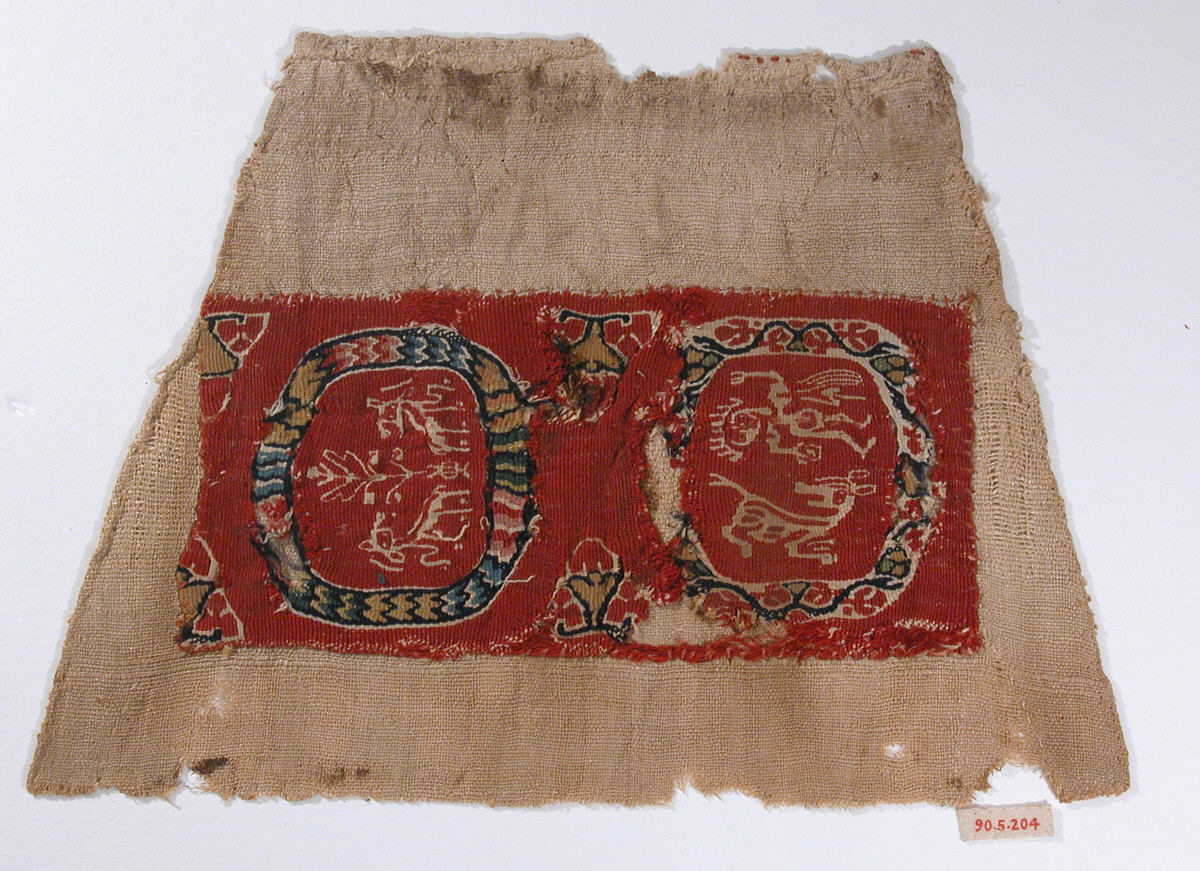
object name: textile fragment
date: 401-600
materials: linen, wool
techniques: weave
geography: egypt